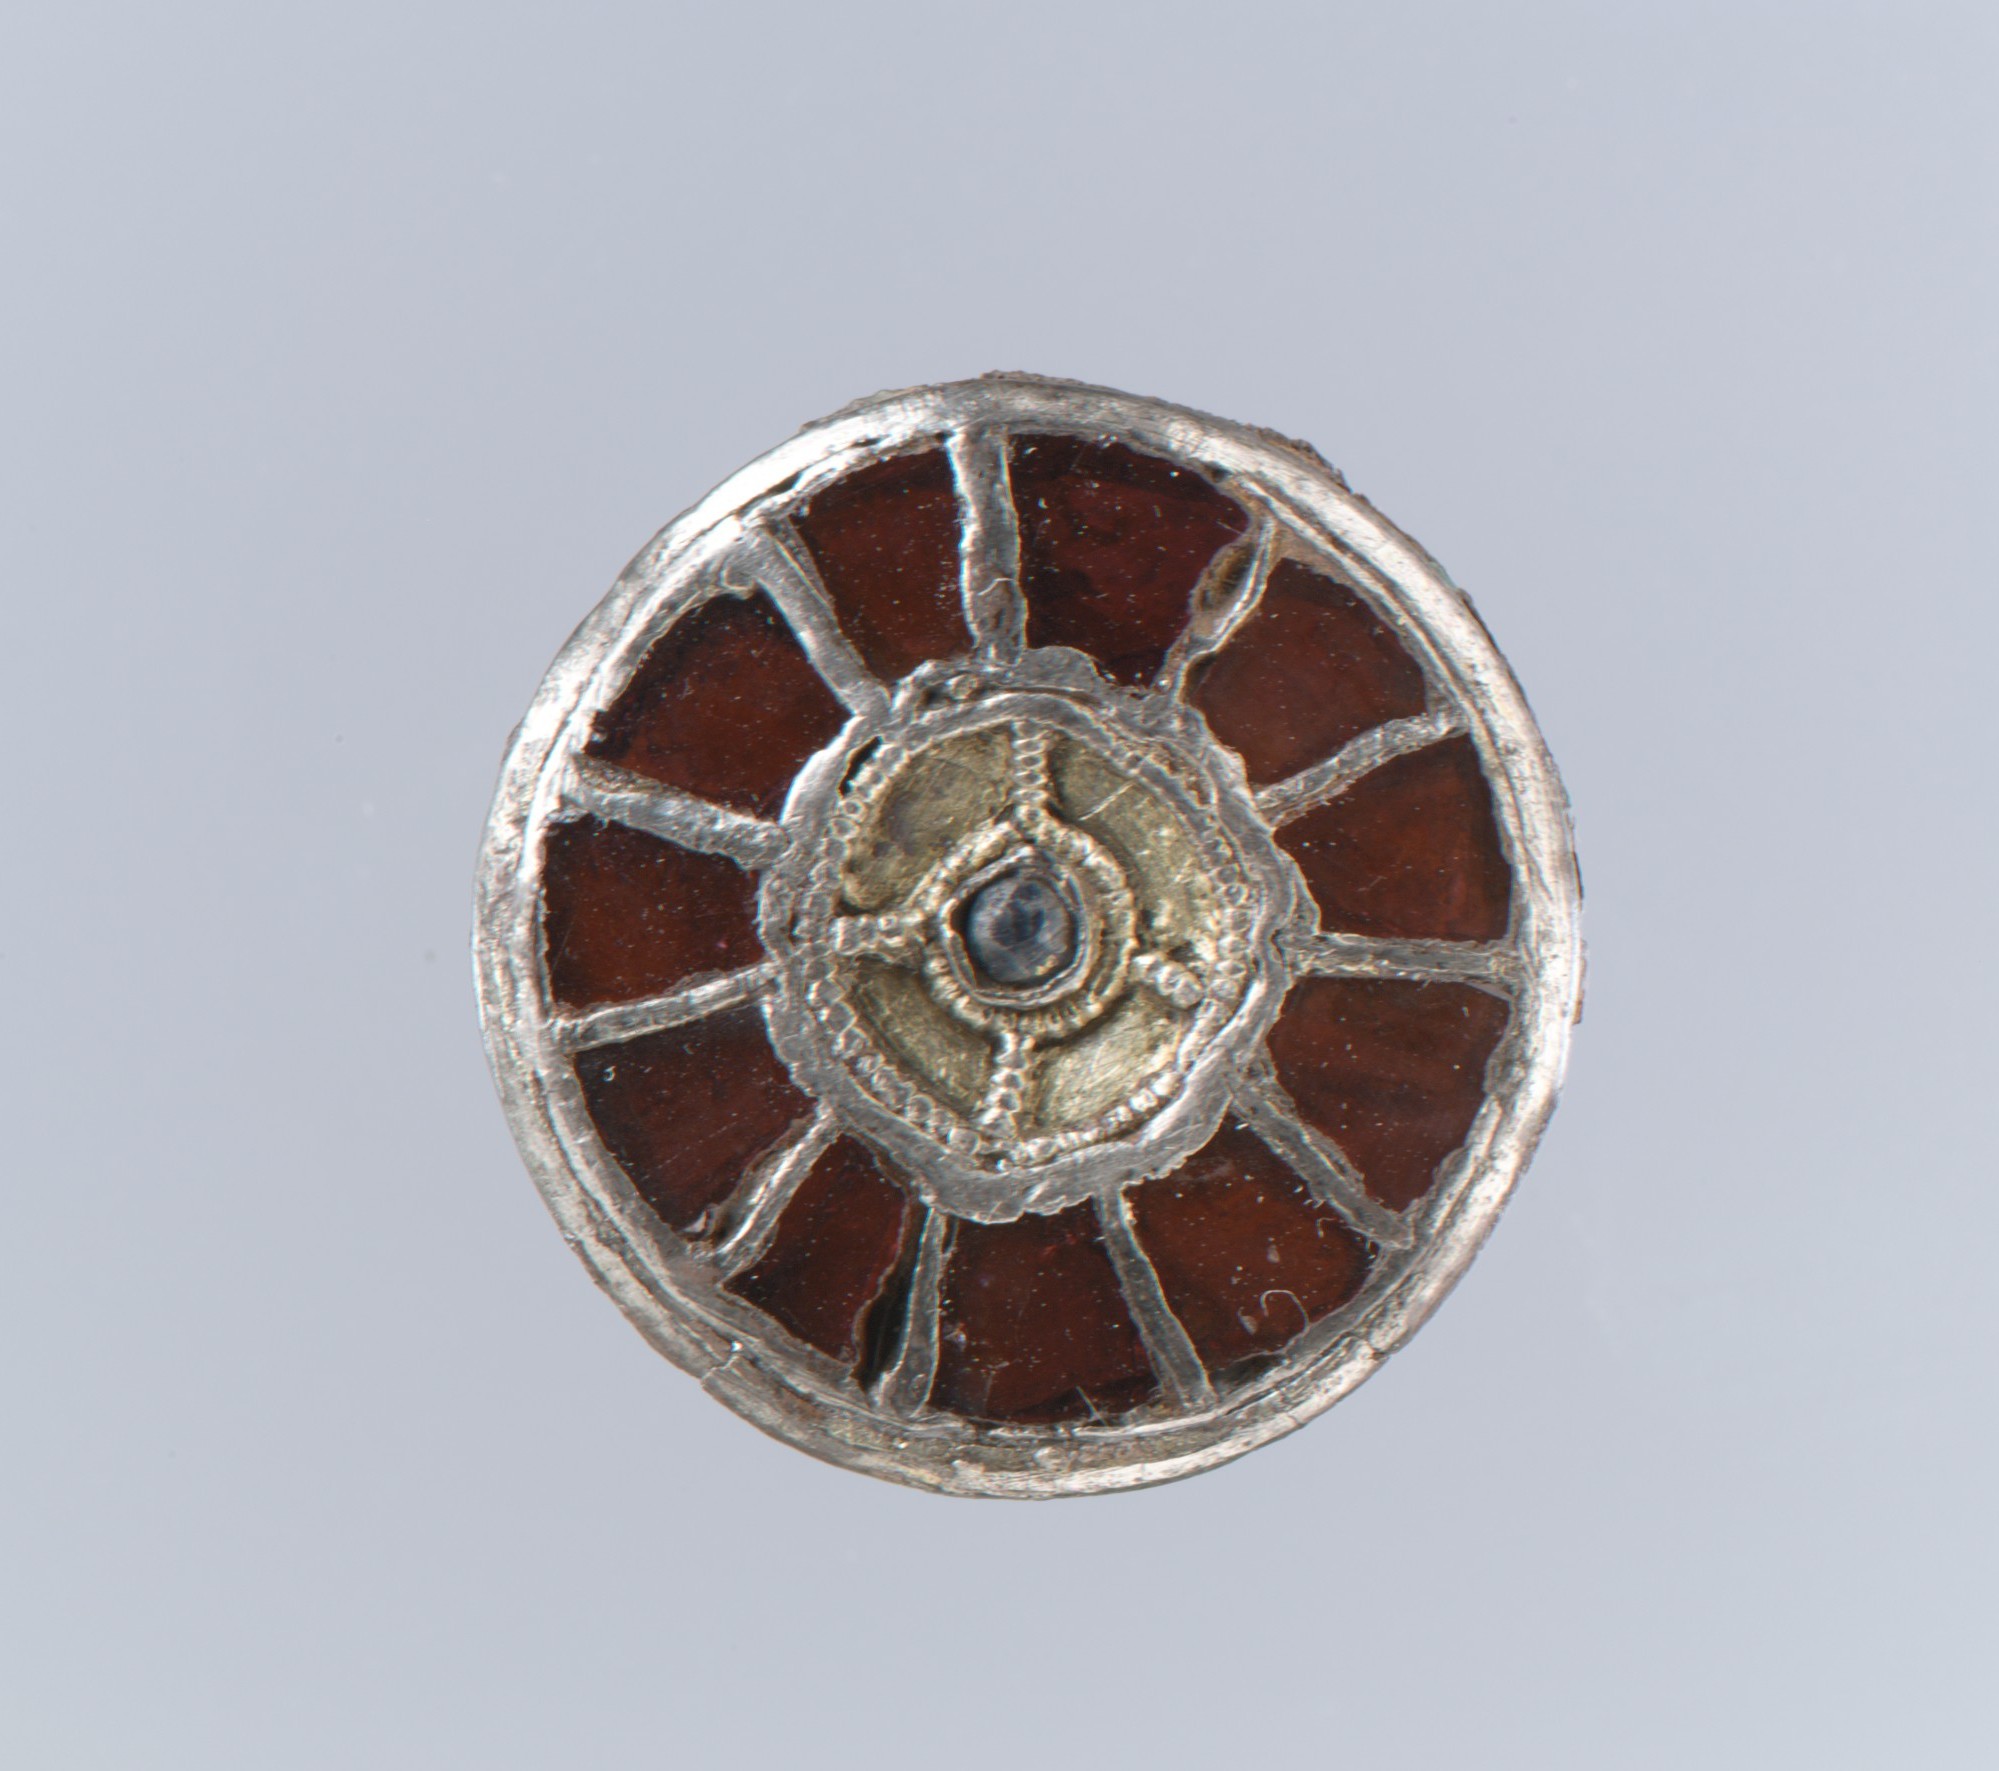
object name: brooch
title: Disk Brooch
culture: frankish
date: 501-550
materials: garnet, glass, silver